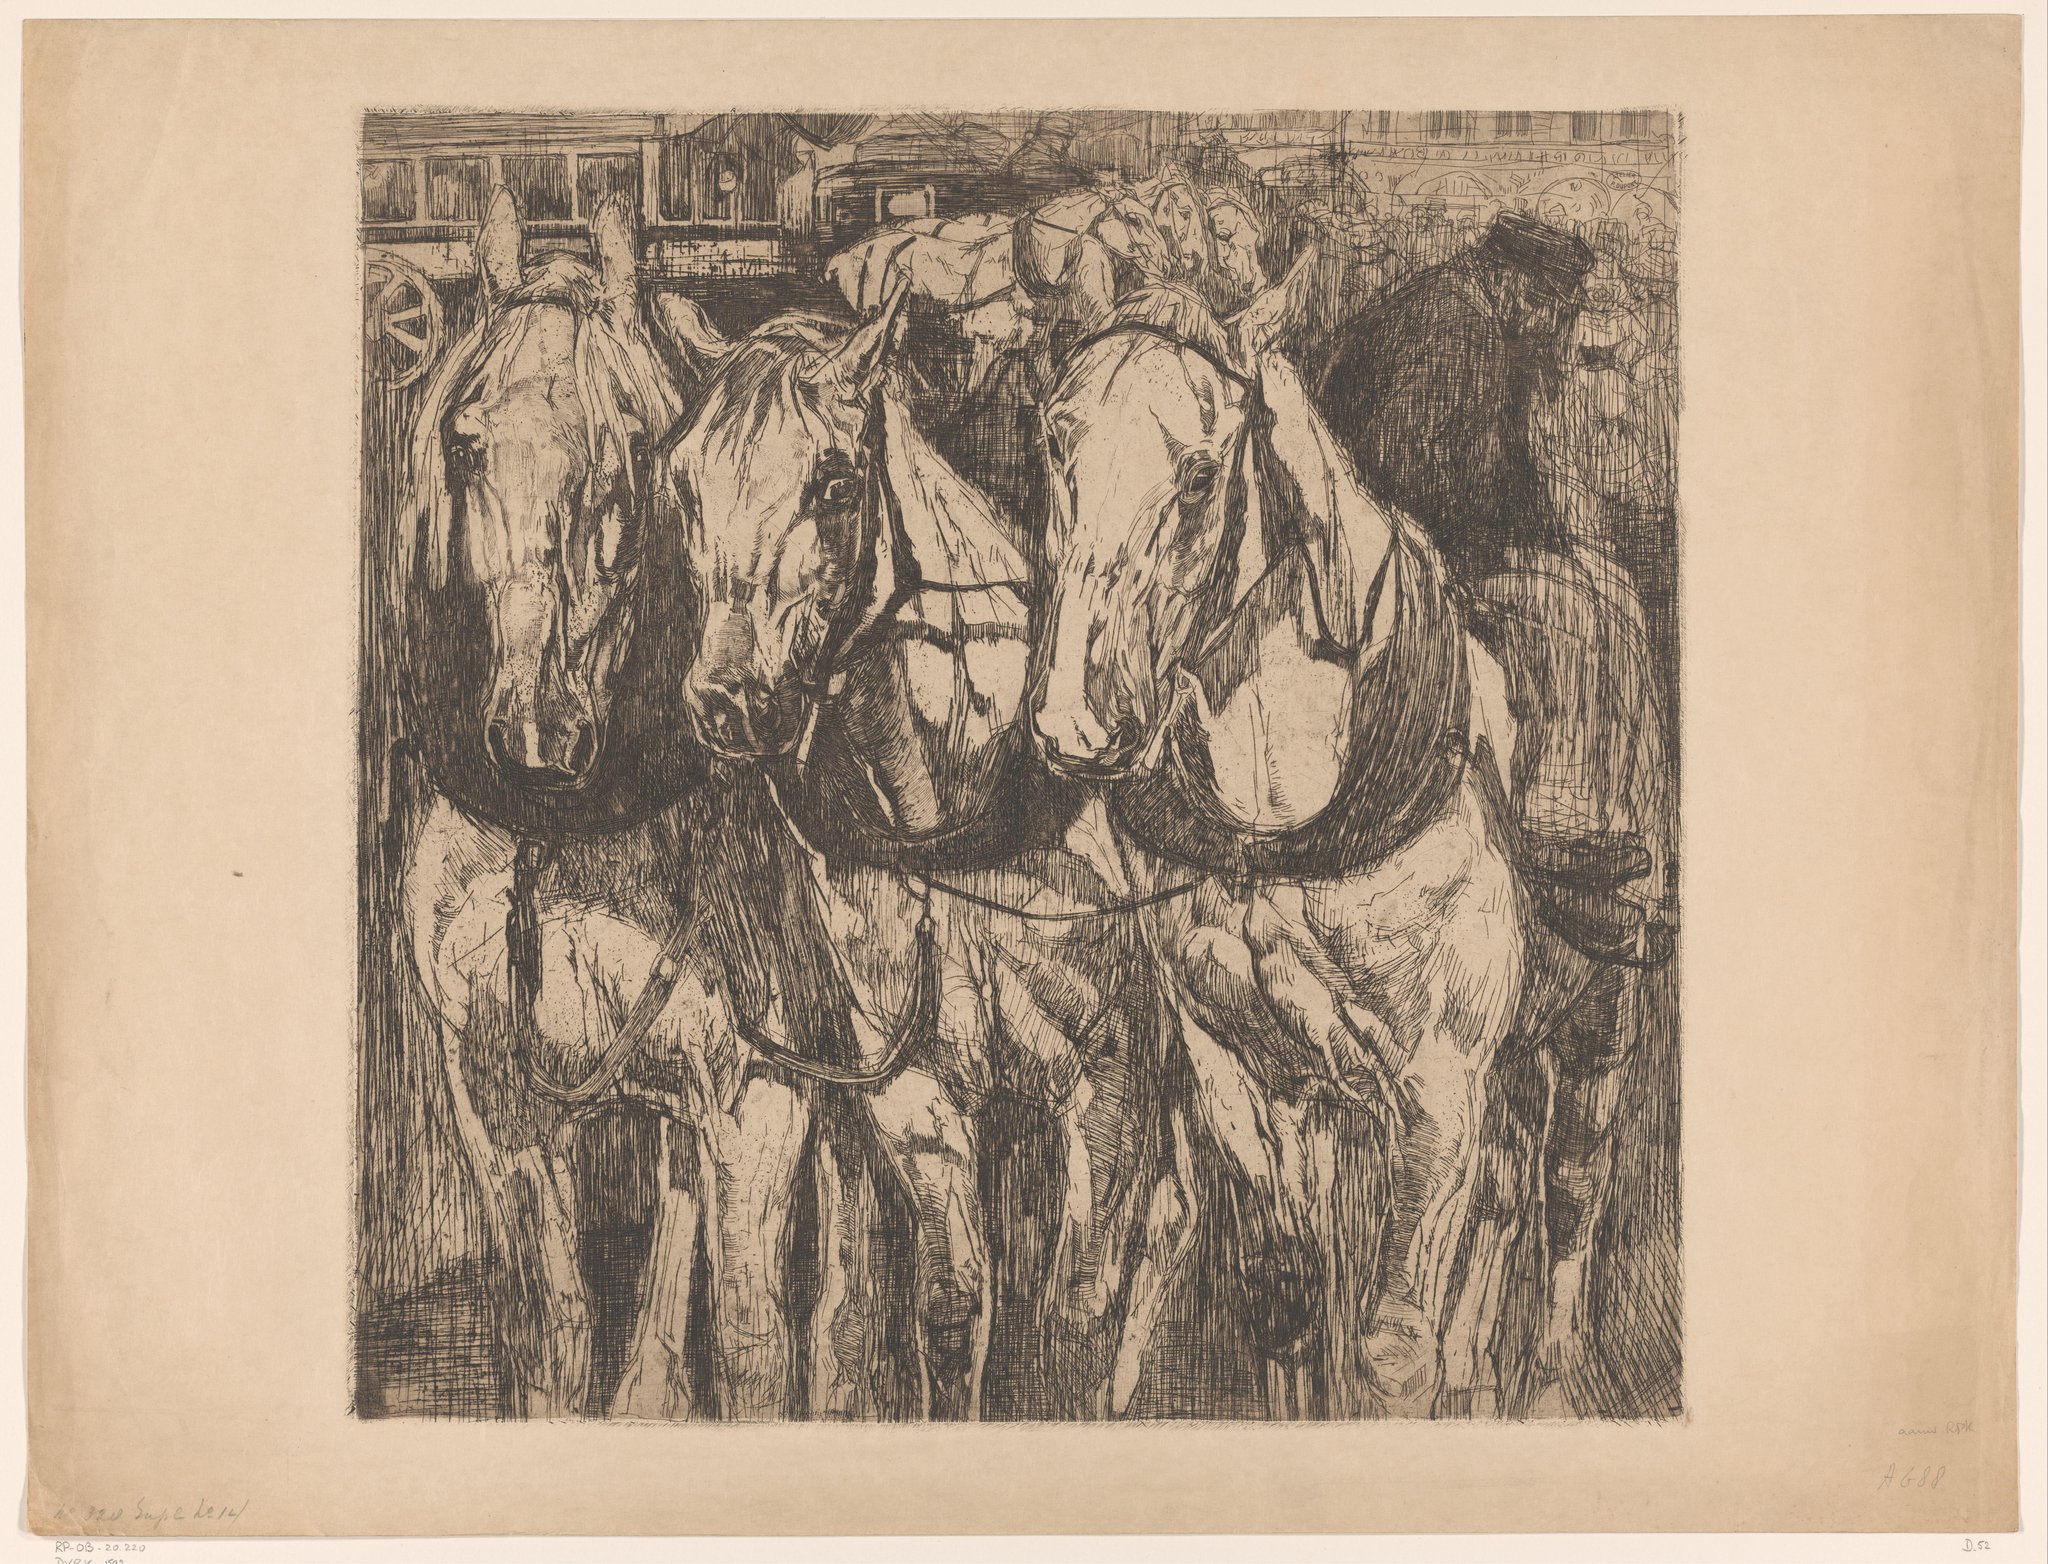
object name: print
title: Drie trekpaarden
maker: pieter dupont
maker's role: draughtsman, print maker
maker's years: 1870-1911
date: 1896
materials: paper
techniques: etching, intaglio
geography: amsterdam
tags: horse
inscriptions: inscription: ‘No. 328 Supl No. 14’